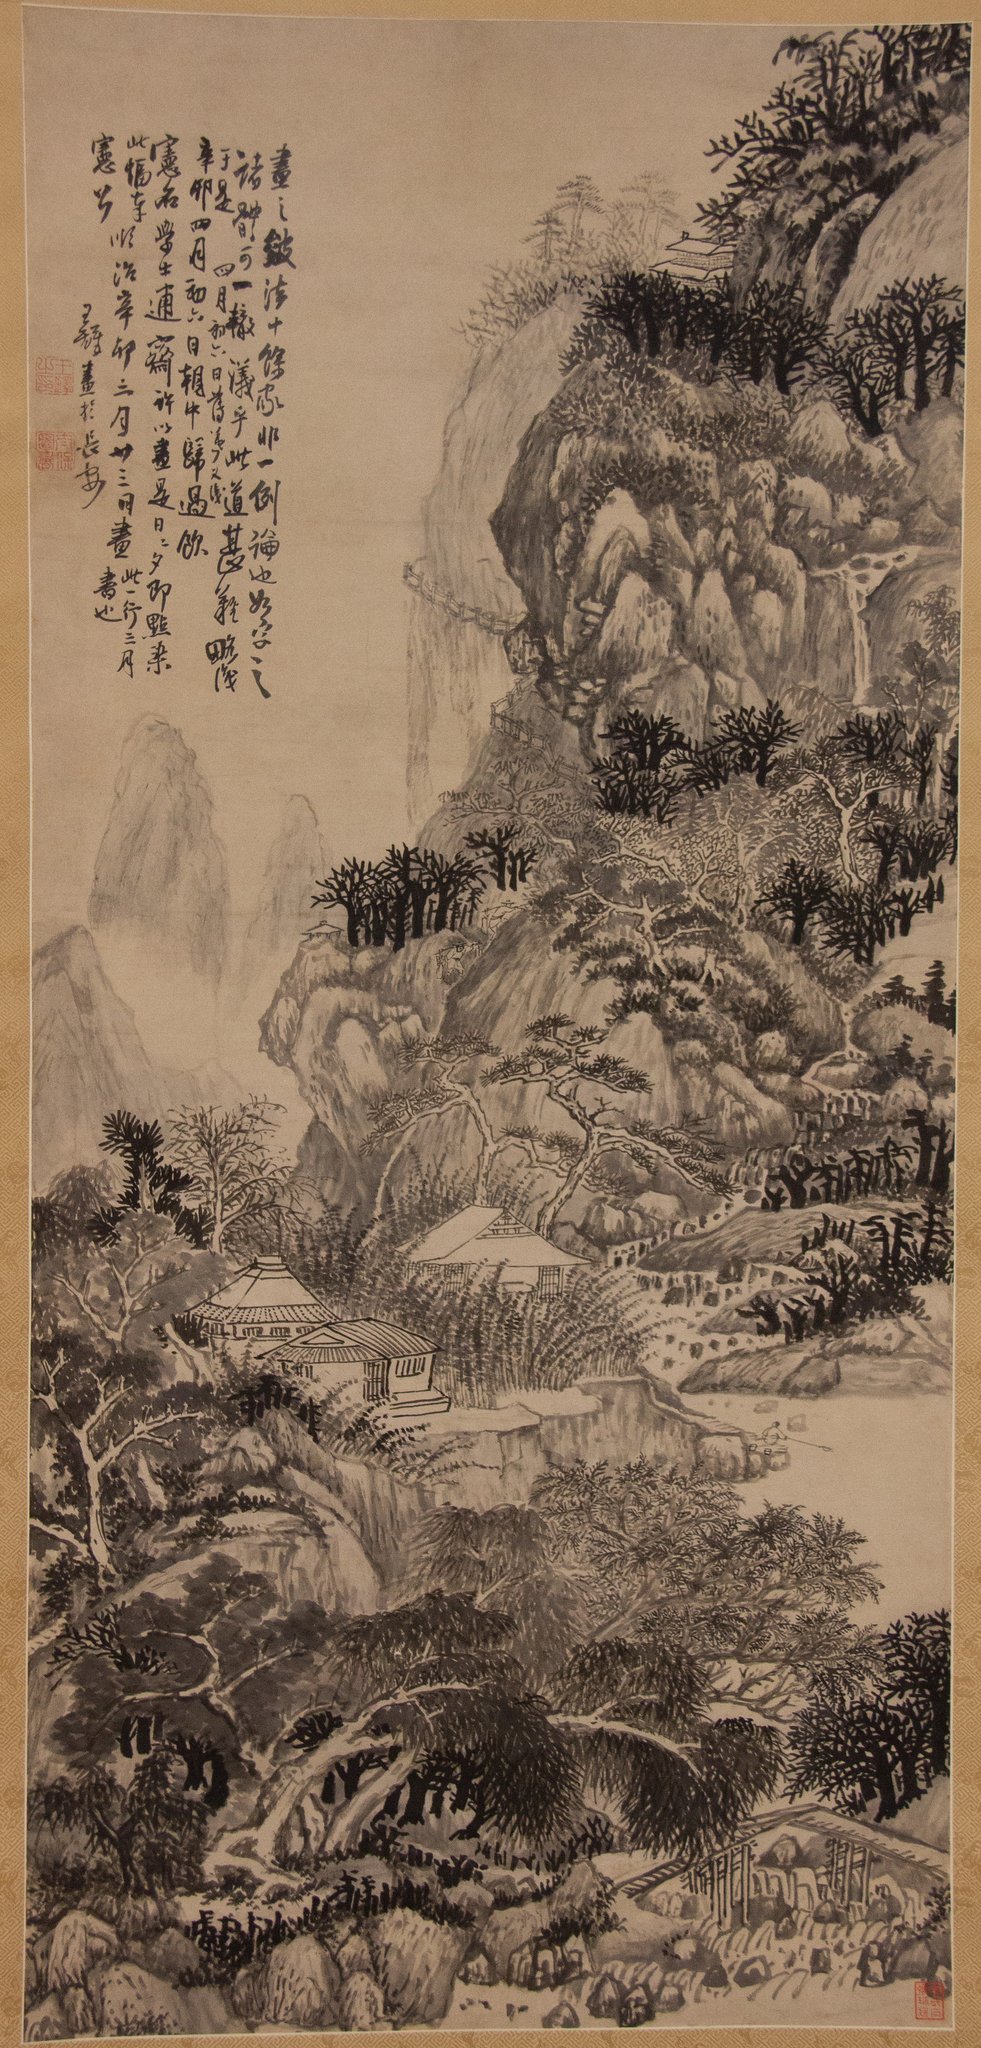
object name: hanging scroll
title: Mountain Landscape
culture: chinese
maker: wang duo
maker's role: artist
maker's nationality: chinese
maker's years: 1592-1652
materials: ink, paper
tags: mountains,landscapes